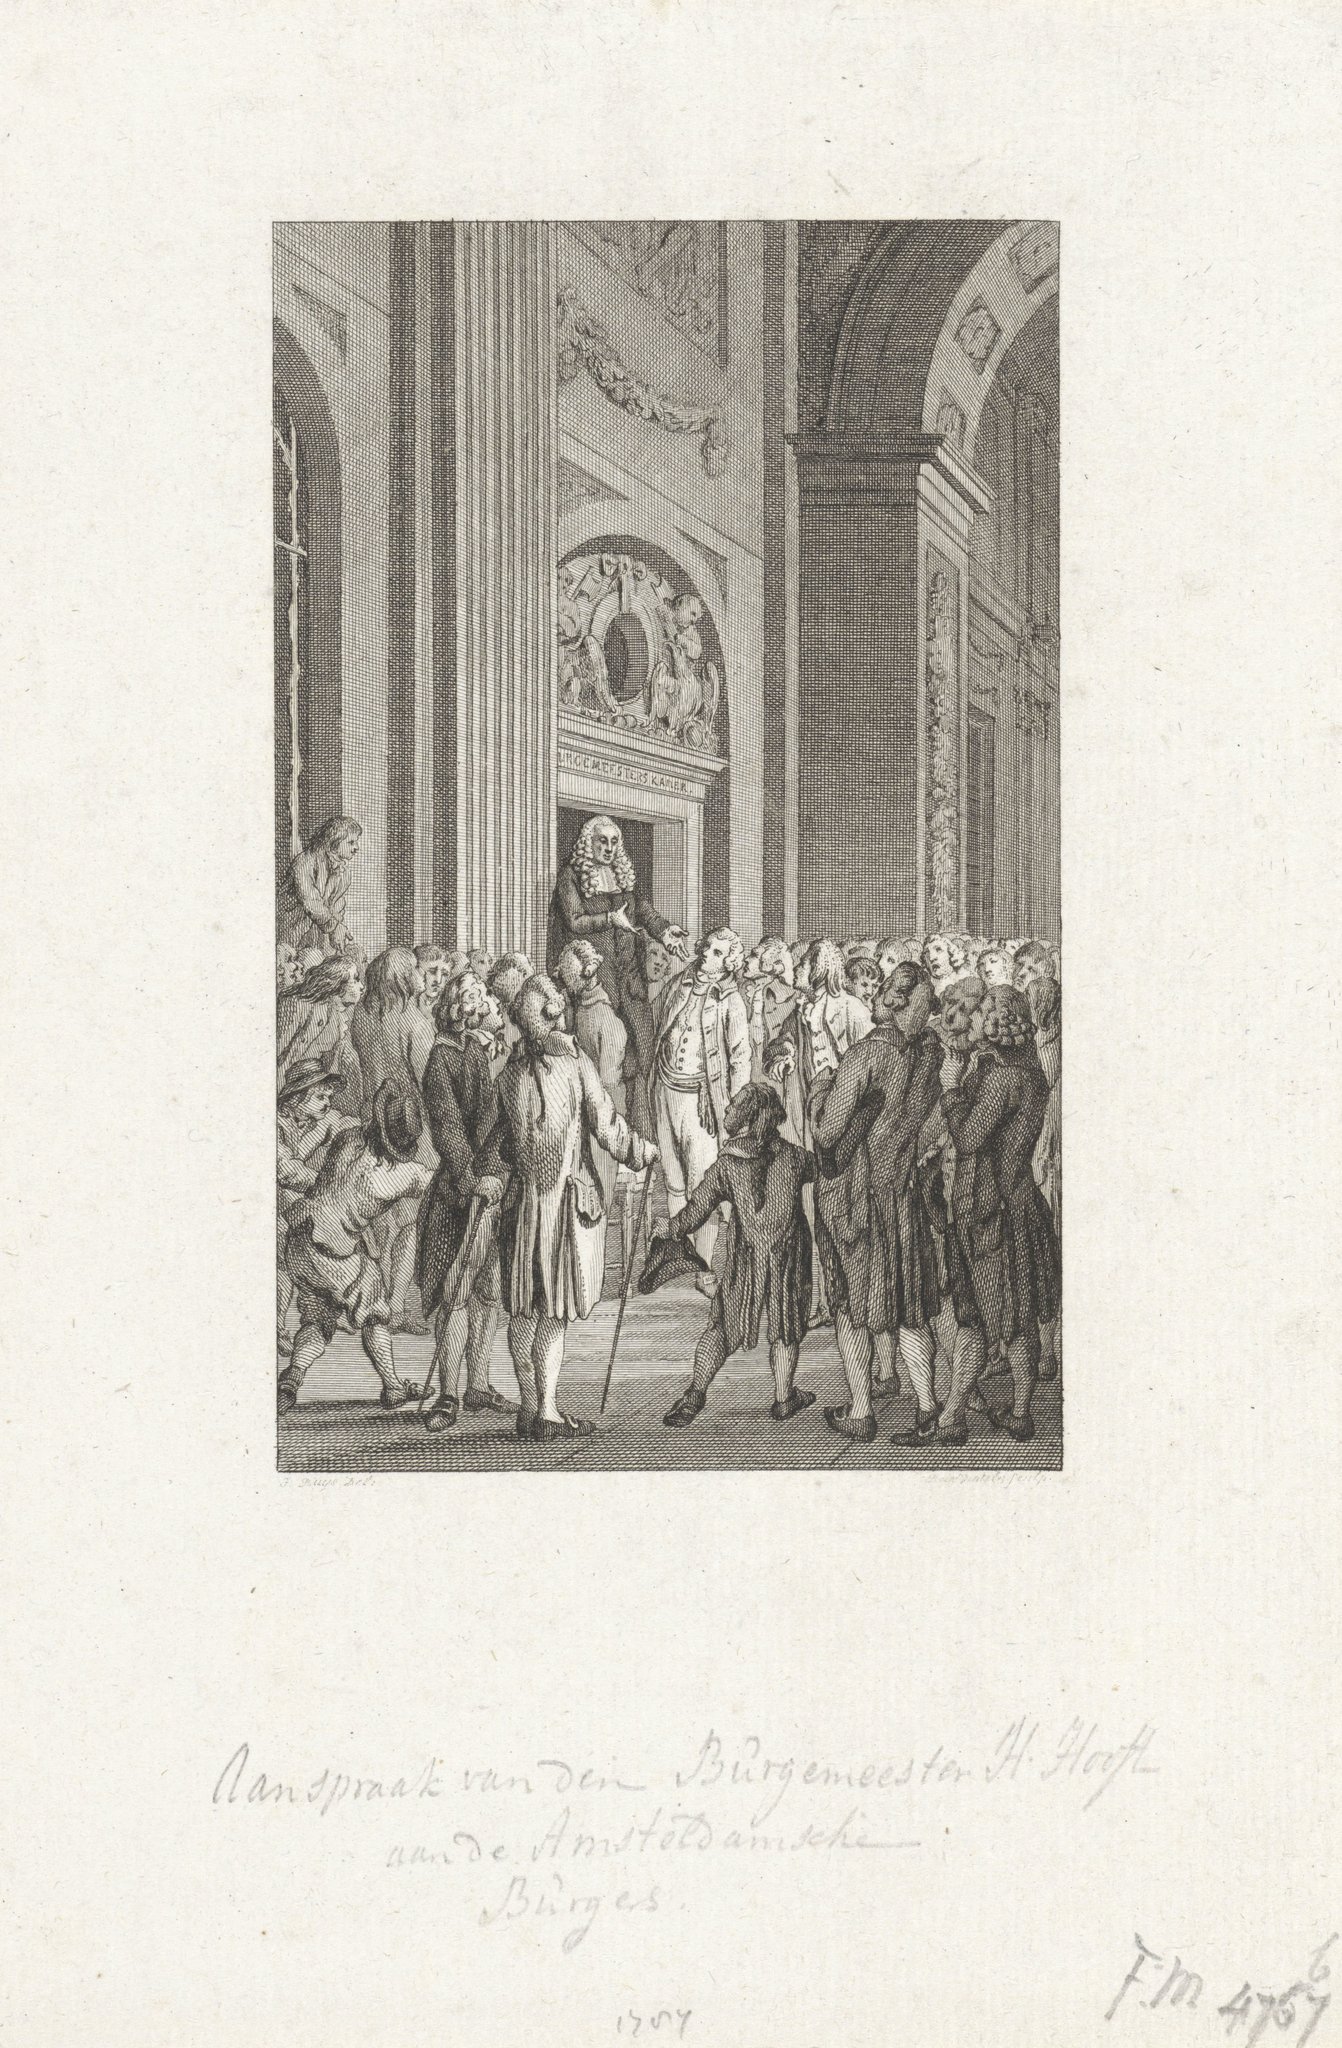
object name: history print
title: Burgemeester Hendrik Hooft Danielsz onderhandelt met de burgerij, 1787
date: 1796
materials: paper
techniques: engraving, etching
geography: amsterdam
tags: amsterdam, hendrik danielsz. hooft, rijngraaf van salm frederik iii, crowd, mob, mayor, burgomaster, person addressing a group, orator, patriots (1780-1795)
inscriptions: collector's mark: Lugt 240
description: De Amsterdamse burgemeester Hendrik Danielsz. Hooft onderhandelt met de burgerij over het afdanken van de Rijngraaf van Salm, 26 februari 1787. Hooft spreekt staande voor de ingang van de burgemeesterskamer in het Stadhuis de samengestroomde burgers toe.